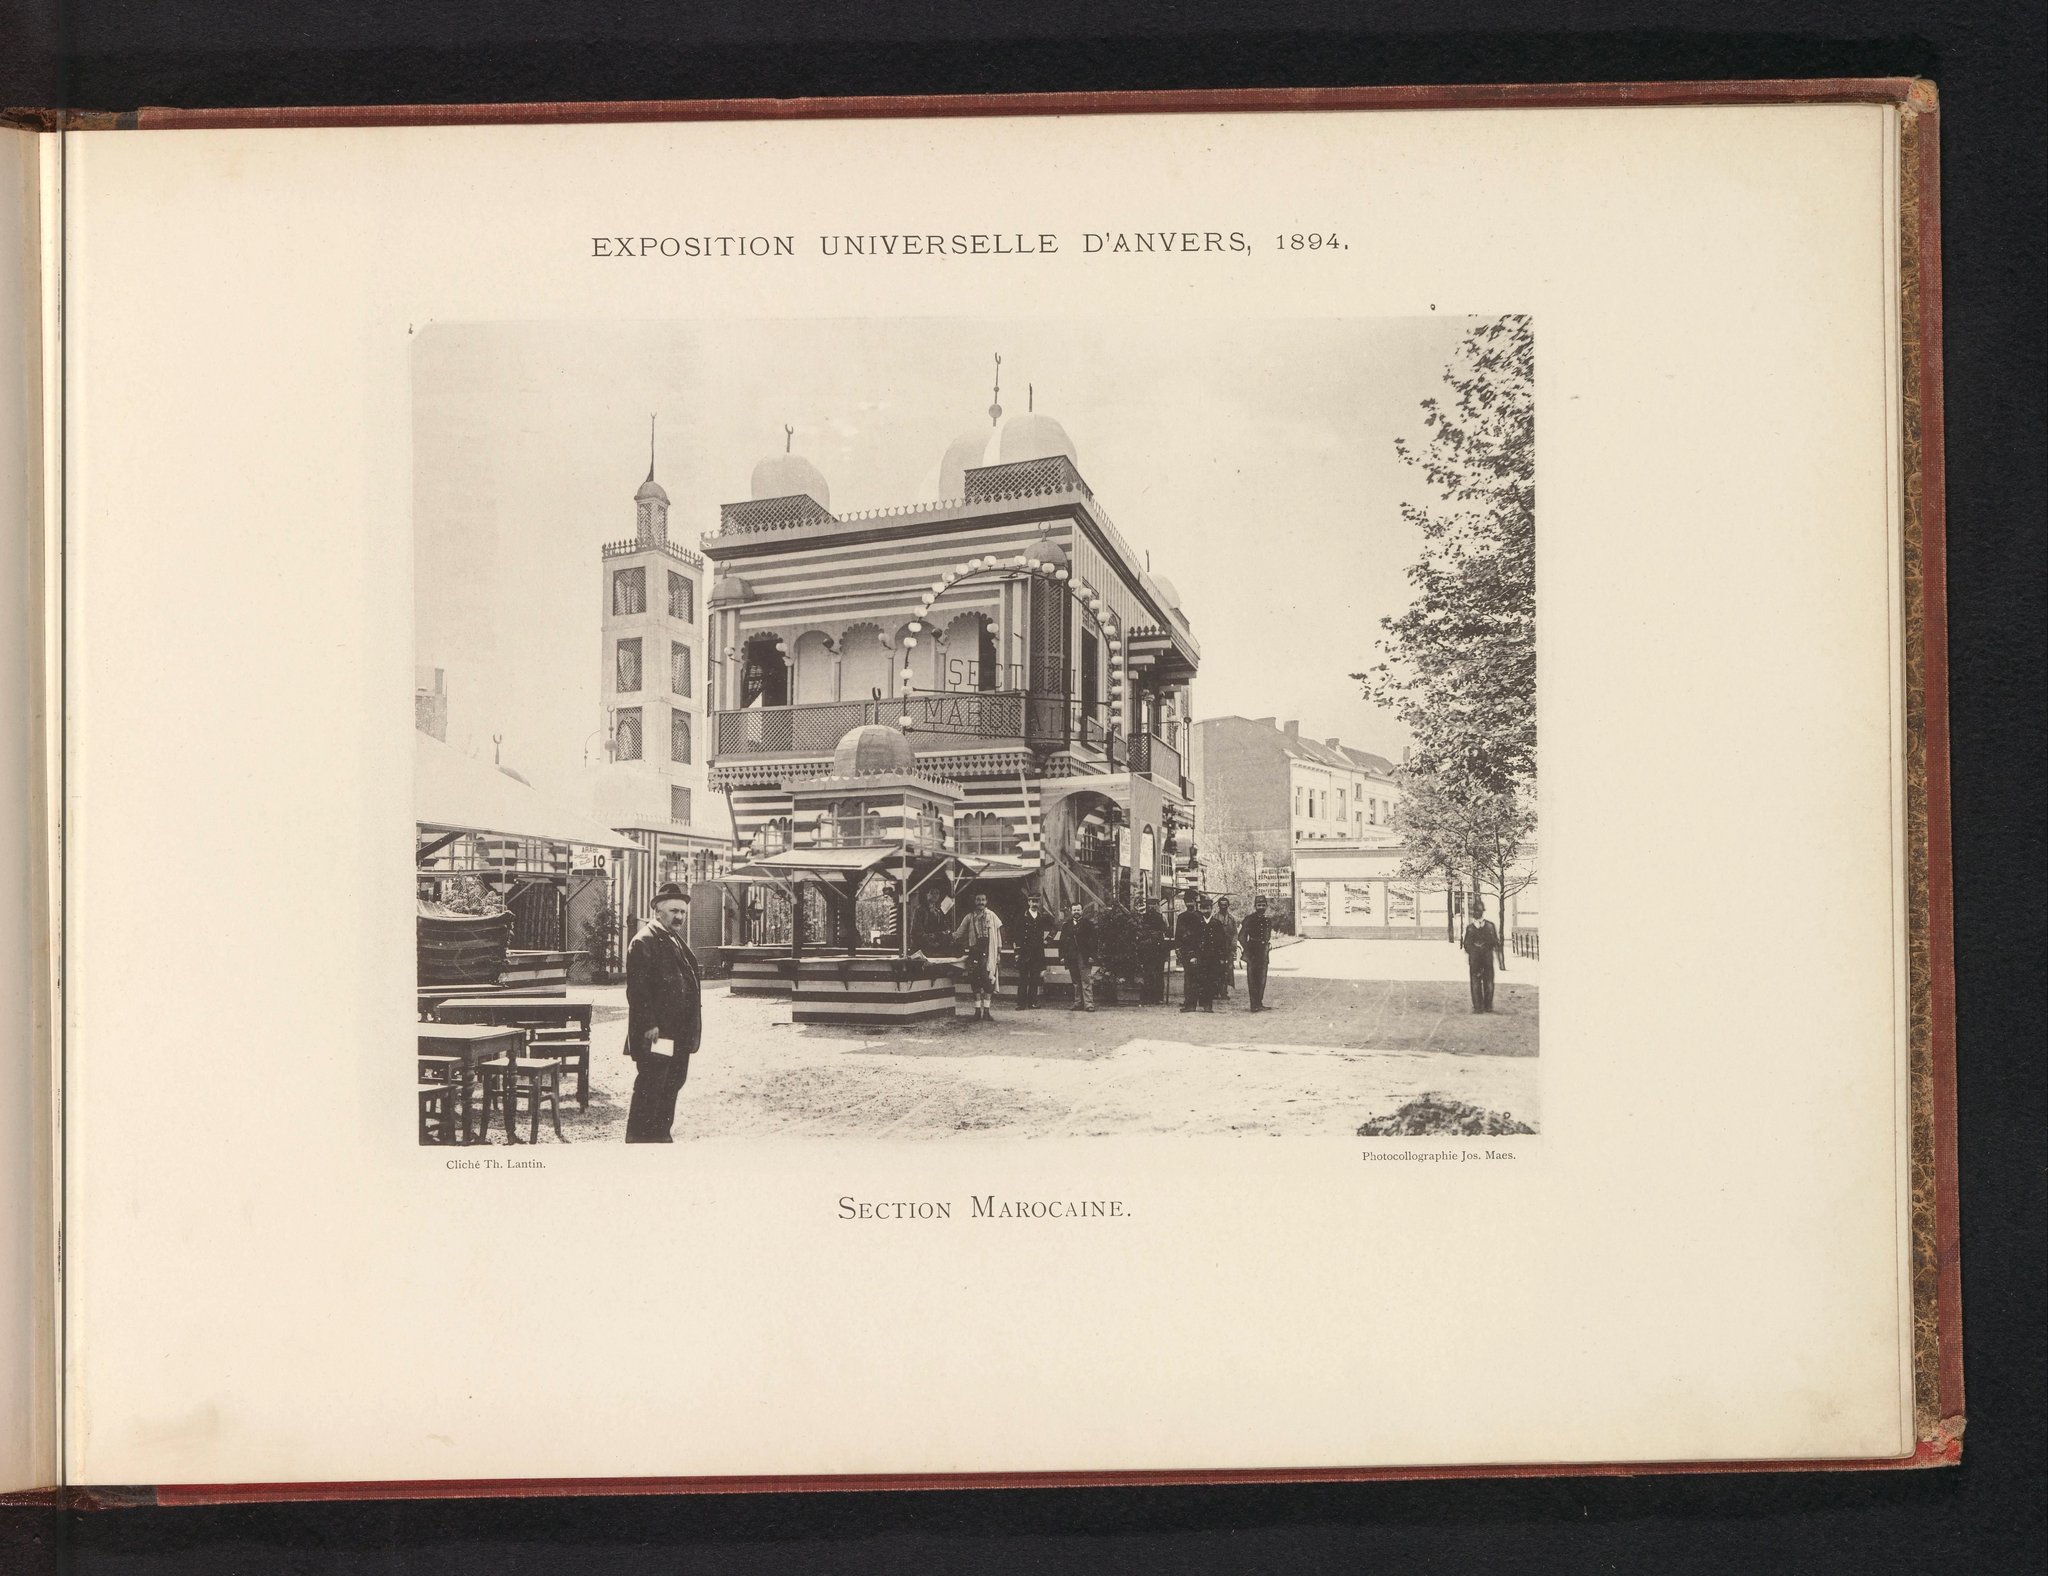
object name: page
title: Section Marocaine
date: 1894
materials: paper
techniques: photograph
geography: antwerp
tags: world fair, world exhibition, façade (of house or building)